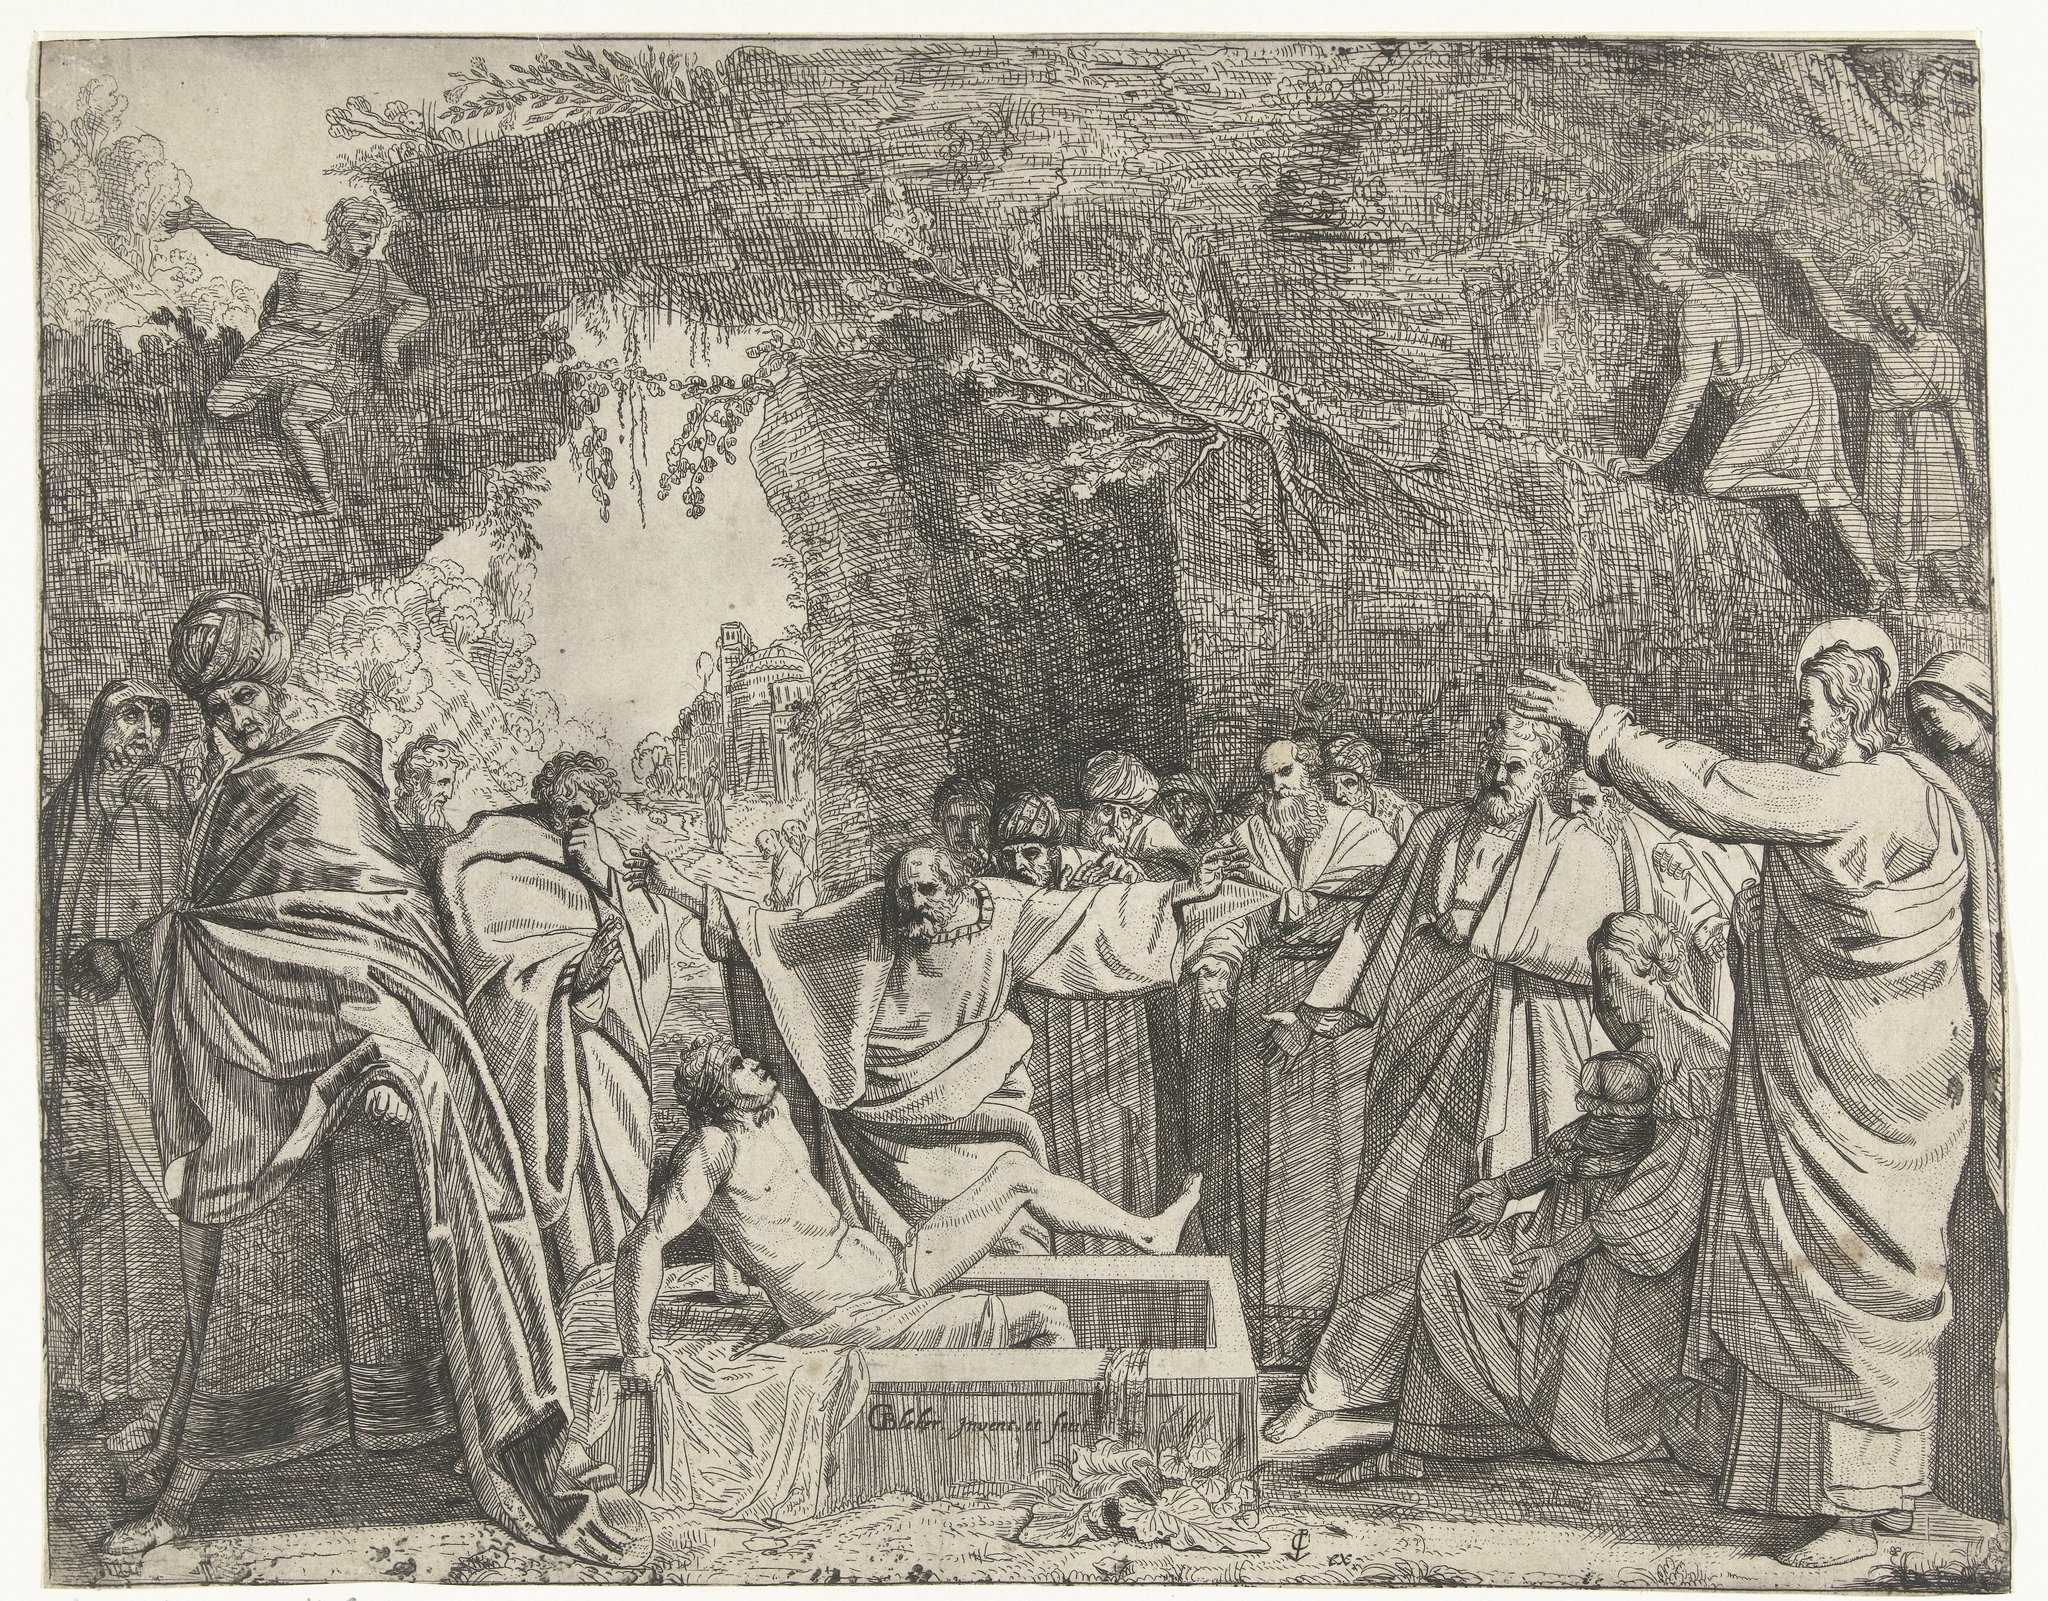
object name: print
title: Opwekking van Lazarus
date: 1622-1656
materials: paper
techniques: etching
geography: haarlem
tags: the raising of lazarus ('lazarus, come out')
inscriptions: collector's mark: Lugt 2228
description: Lazarus staat op uit zijn kist nadat Christus hem geroepen heeft. Naast Christus staan Marta en Maria. Een van de verbaasde omstanders houdt zijn mantel voor zijn neus om zich te beschermen tegen de lijklucht.